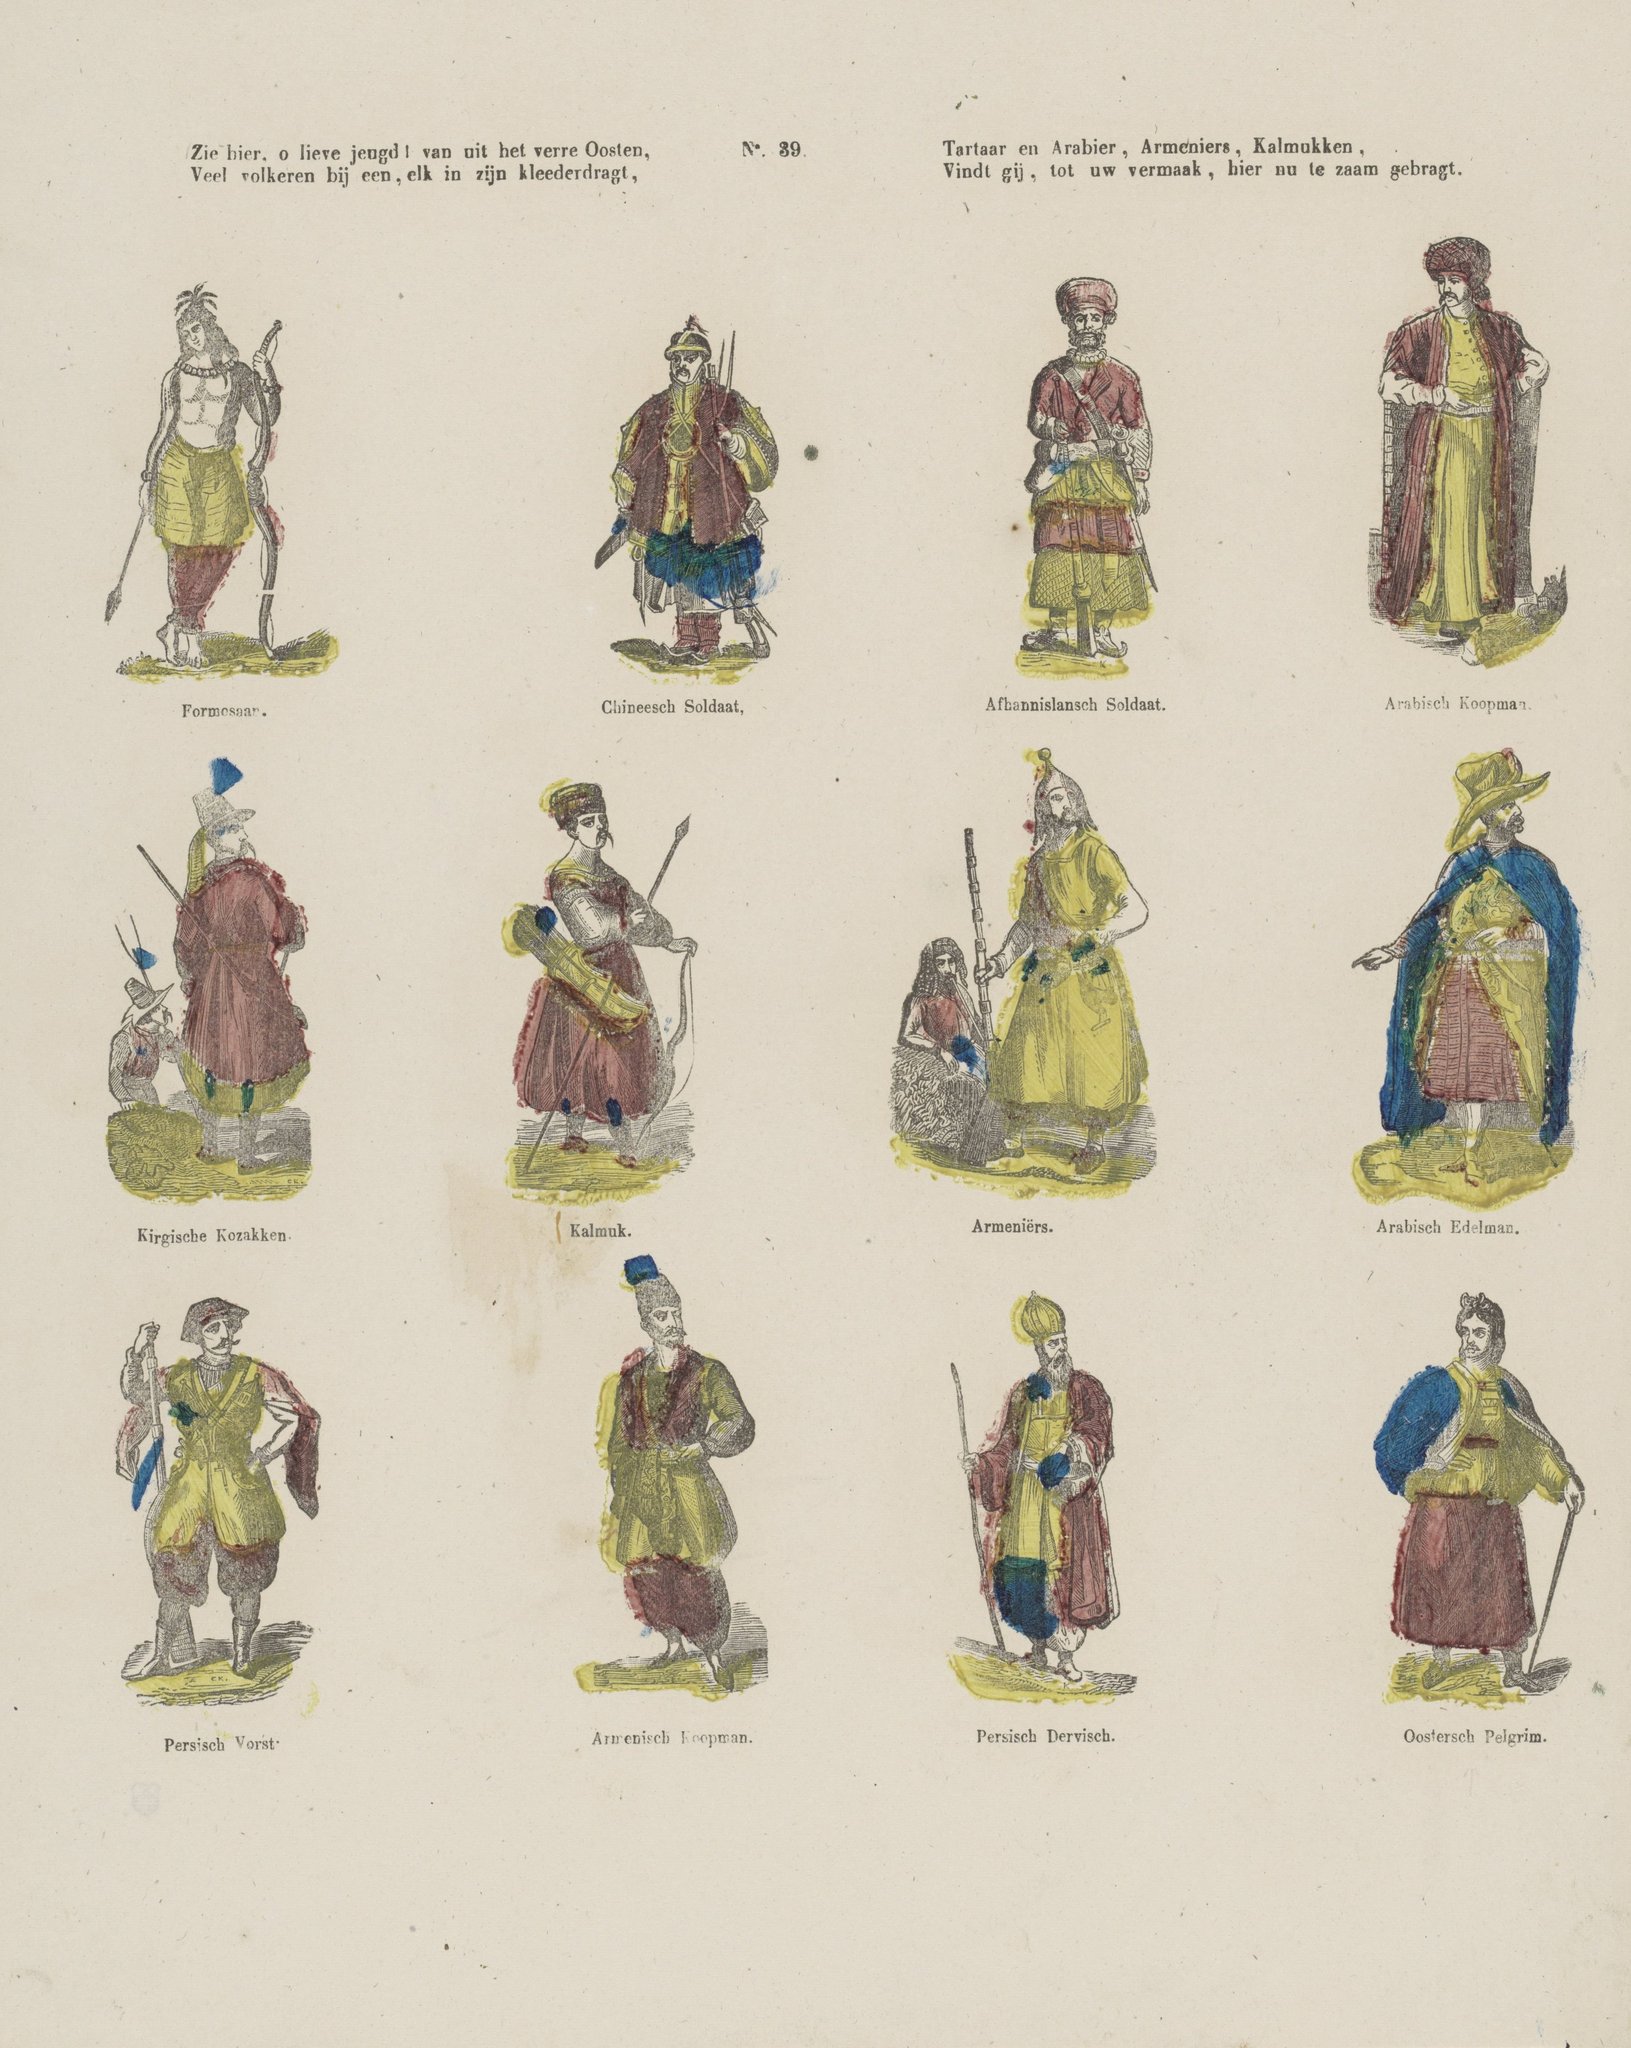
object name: popular print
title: Zie hier, o lieve jeugd! van uit het verre Oosten, / Veel volkeren bij een, elk in zijn kleederdragt, / Tartaar en Arabier, Armeniers, Kalmukken, / Vindt gij, tot uw vermaak, hier nu te zaam gebragt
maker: Anonymous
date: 1848-1881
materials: paper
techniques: colour, letterpress printing, engraving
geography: netherlands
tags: asiatic races and peoples, human types, characters (human types)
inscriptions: collector's mark: Lugt 2760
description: Blad met 12 voorstellingen van verschillende figuren uit het Oosten. Onder elke afbeelding een onderschrift. Genummerd midden boven: No. 39.